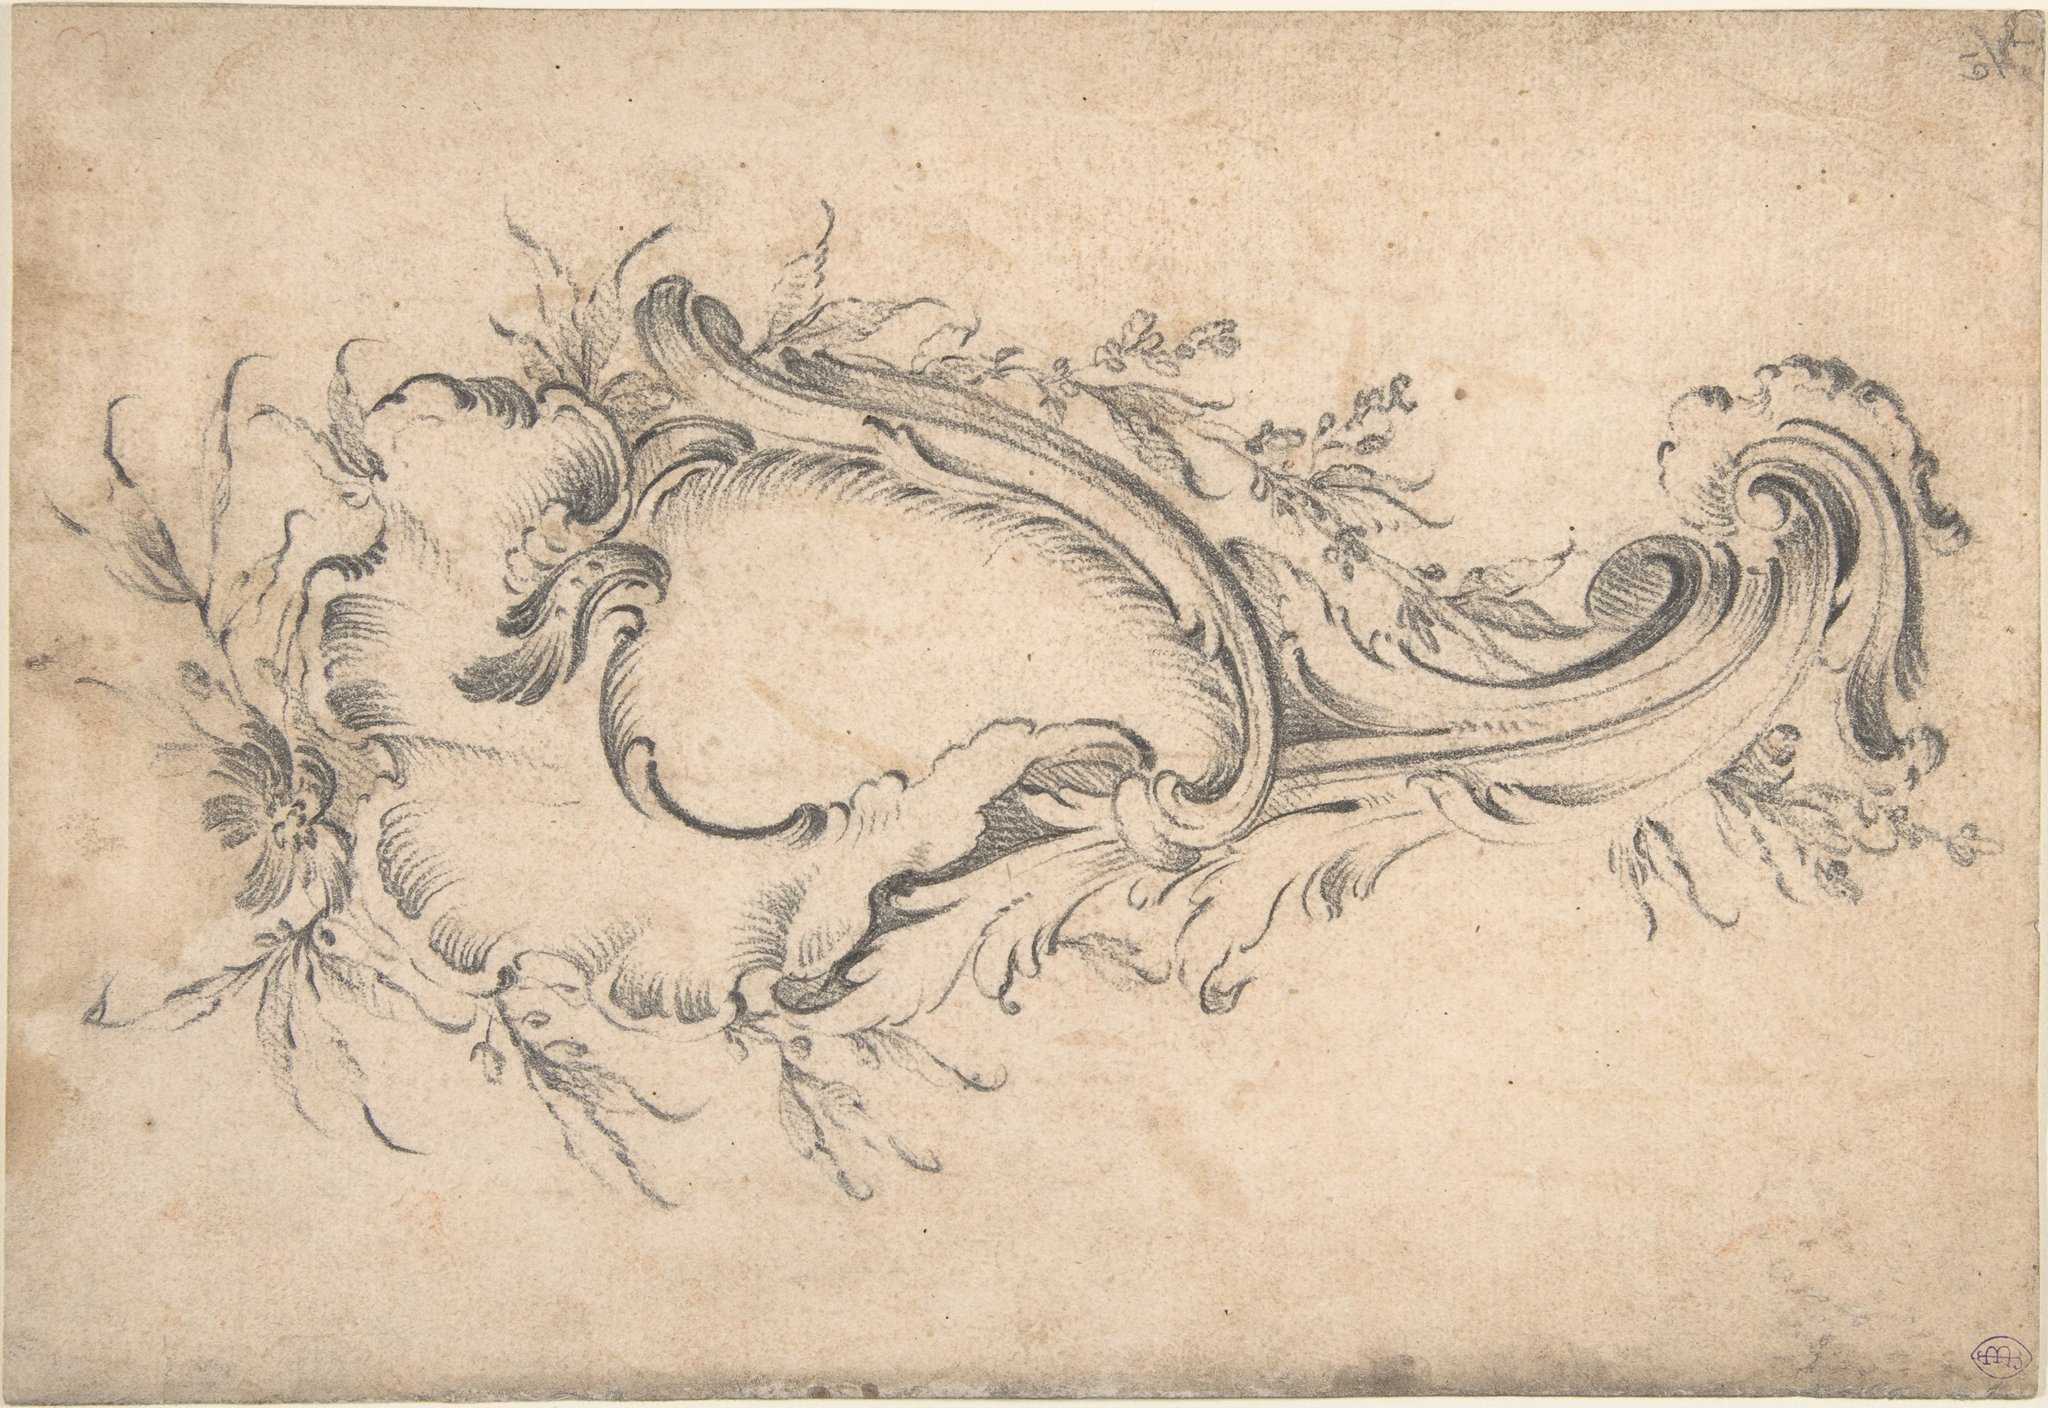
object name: drawing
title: Rococo Cartouche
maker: anonymous, french, 18th century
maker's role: artist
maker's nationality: french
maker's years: 1700-1800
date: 1700-1799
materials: crayon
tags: cartouches